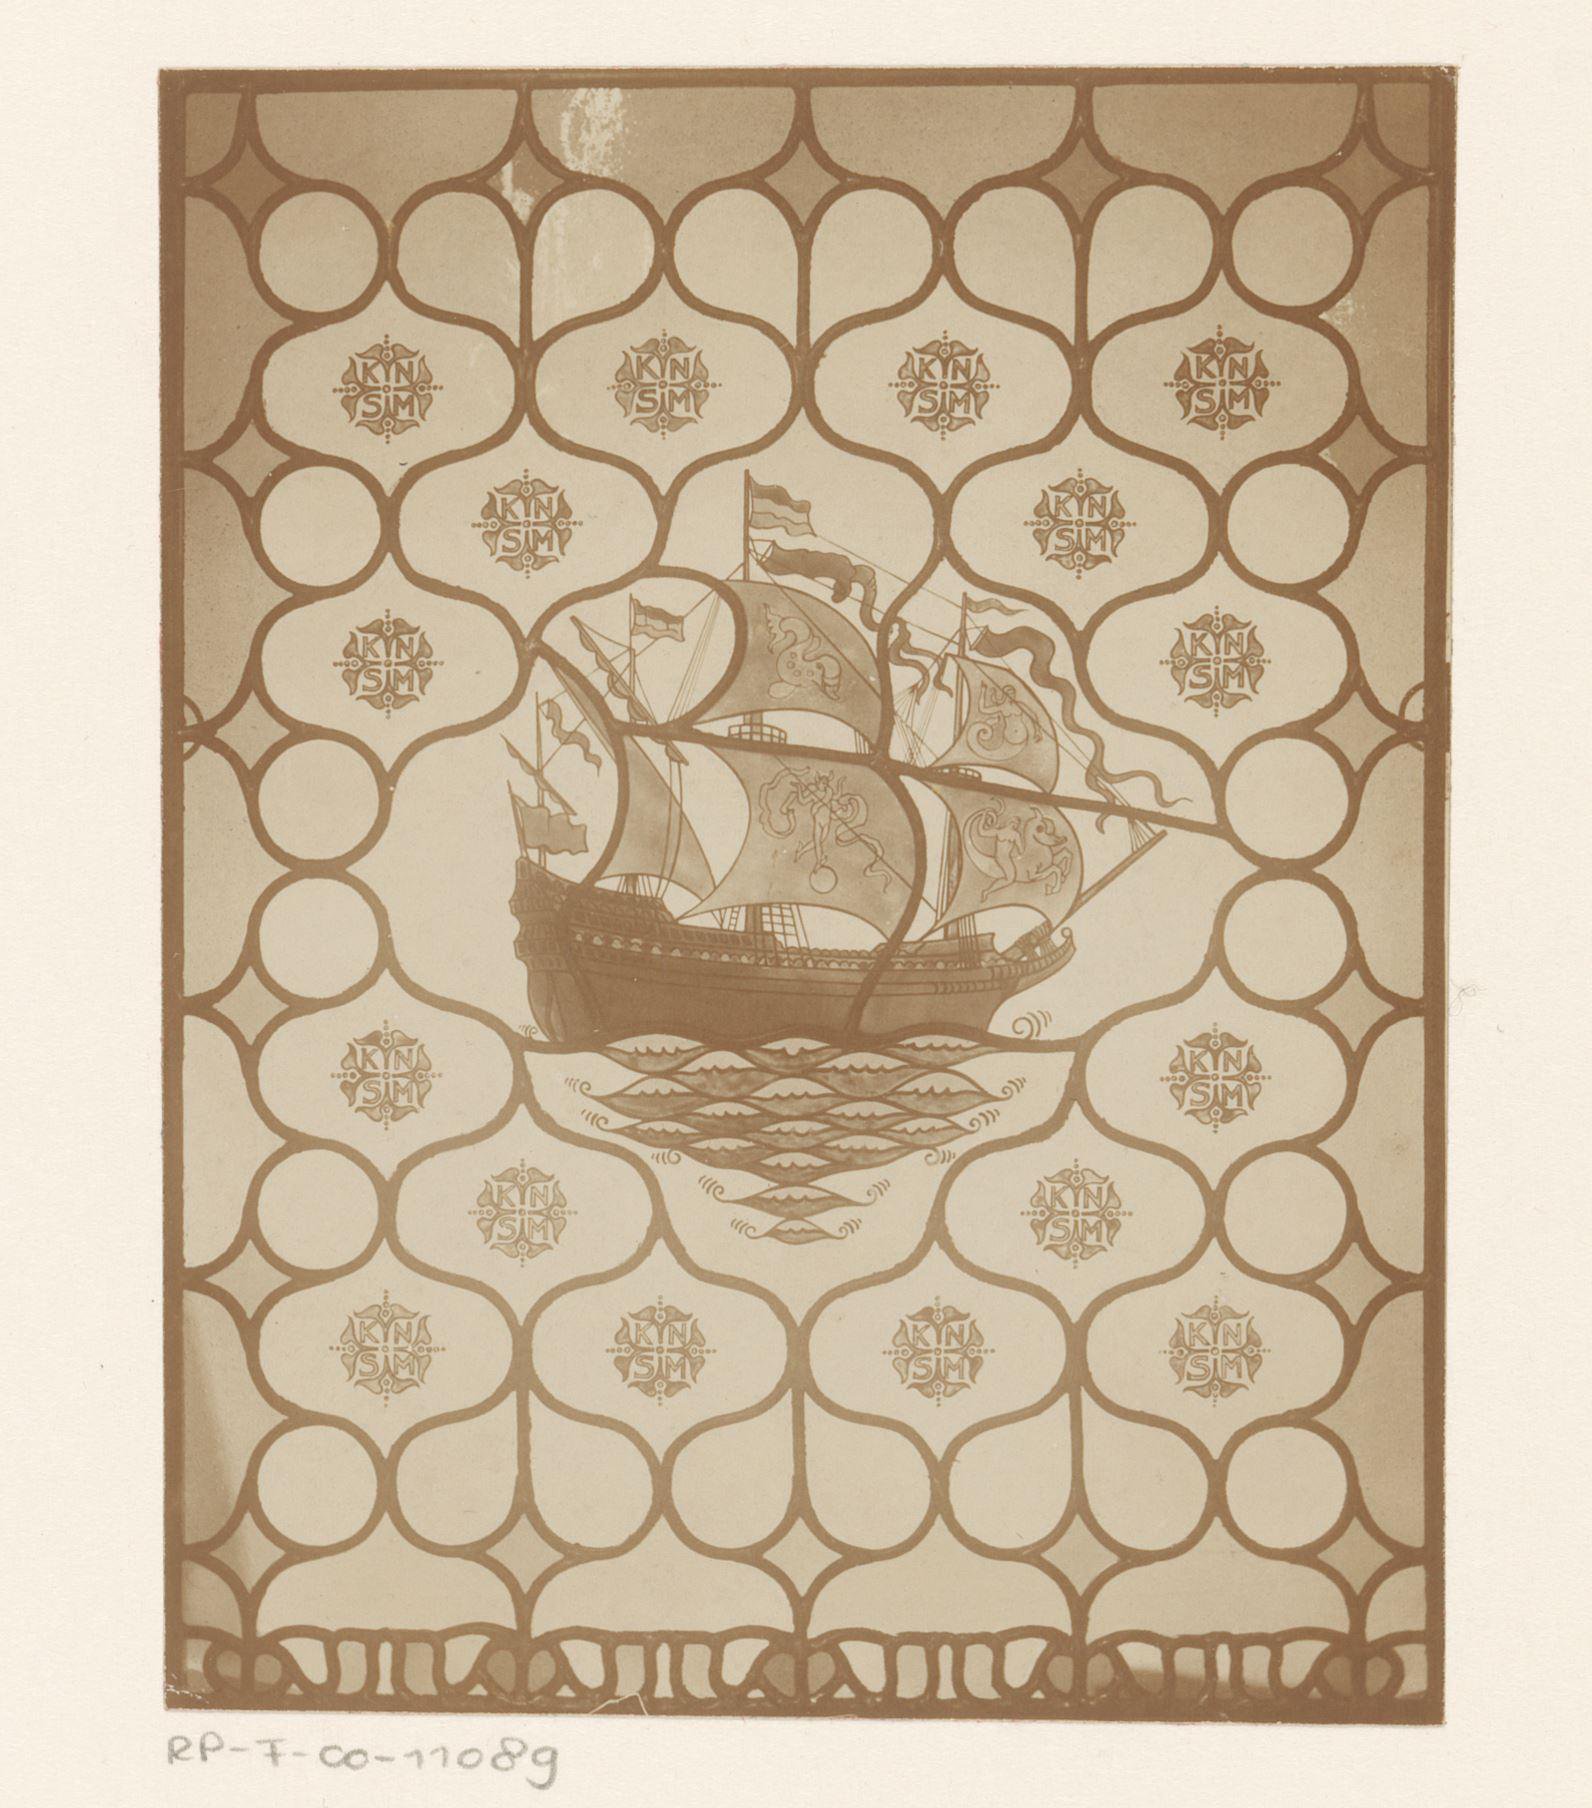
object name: photograph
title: Glas in loodraam met een schip en vignet van de Koninklijke Nederlandse Stoomboot-Maatschappij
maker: Anonymous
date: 1907-1930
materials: photographic support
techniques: collodion silver print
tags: sailing-ship, sailing-boat, work of monumental art